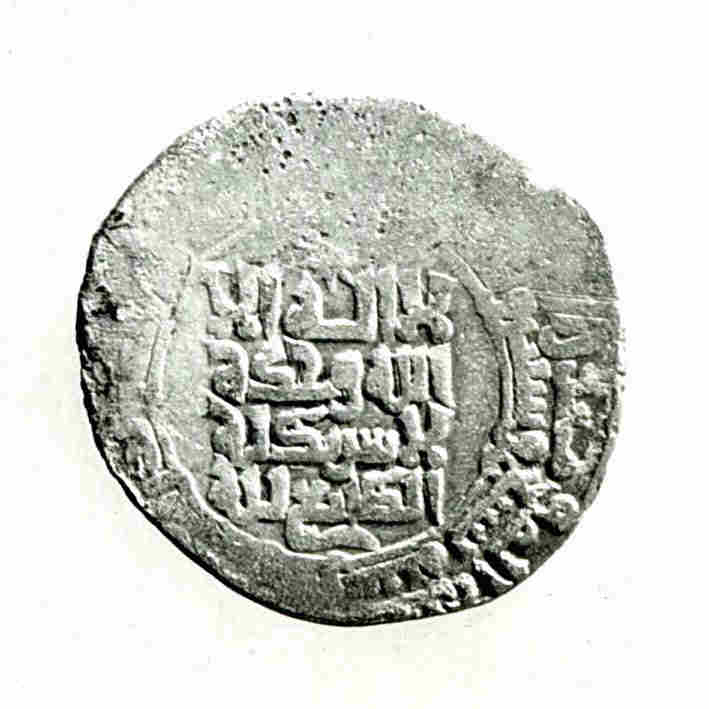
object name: coin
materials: silver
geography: iran